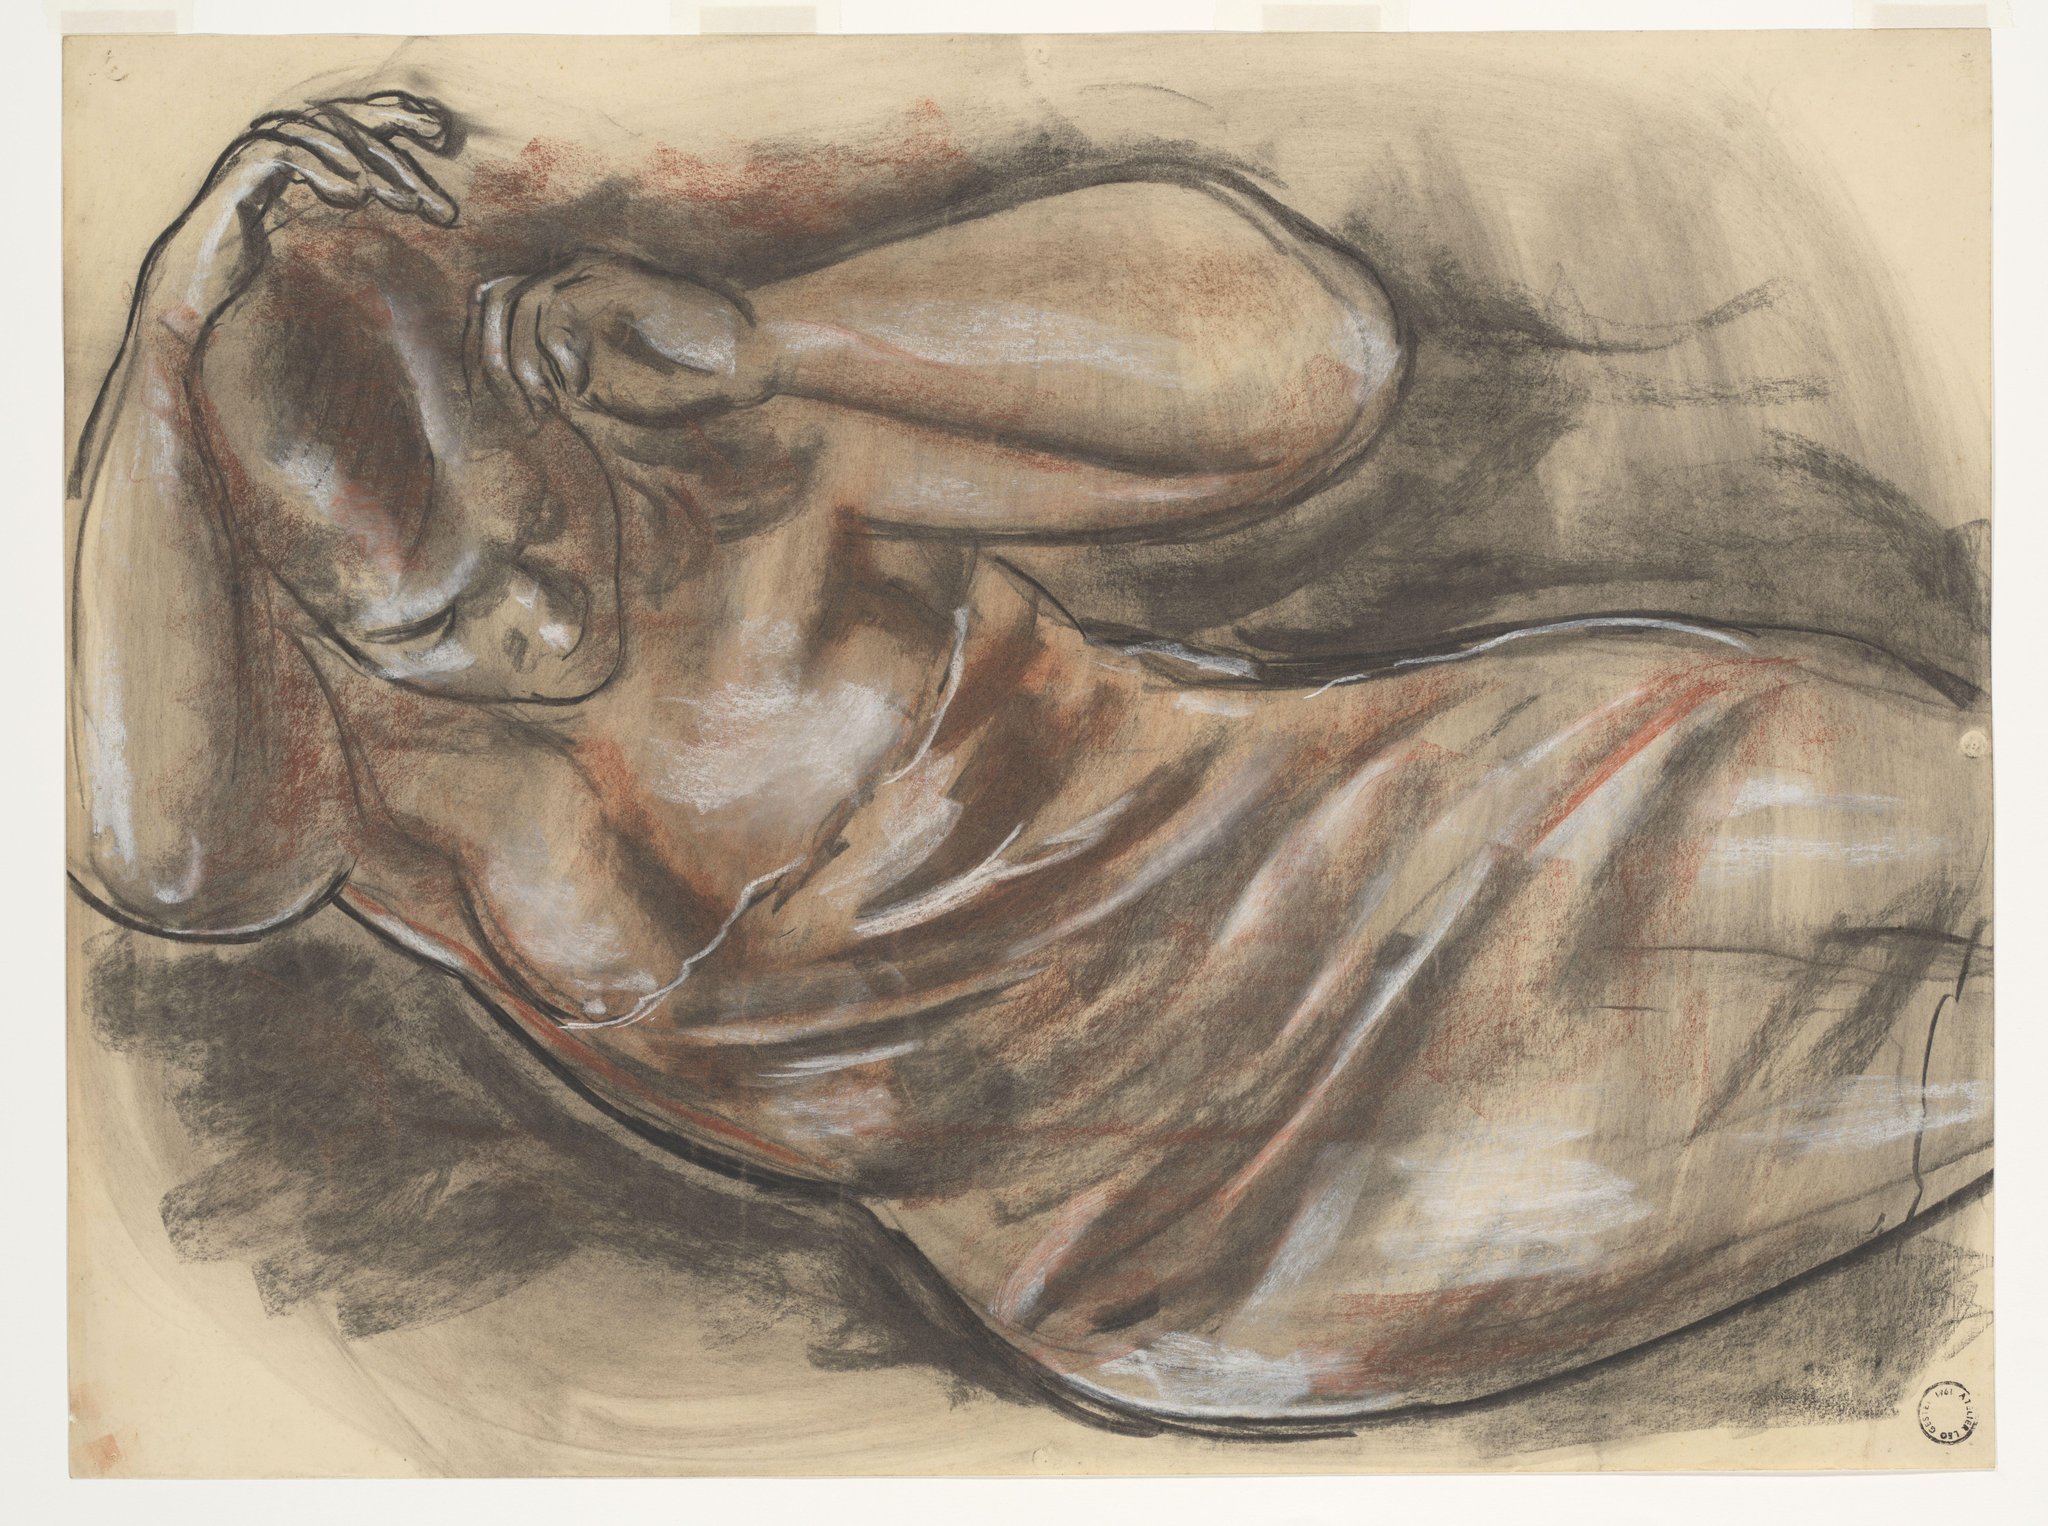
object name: drawing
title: Liggend naakt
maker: leo gestel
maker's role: draughtsman, print maker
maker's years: 1881-1941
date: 1930-1941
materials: chalk, charcoal, paper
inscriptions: workshop stamp (): ‘ATELIER LEO GESTEL 1941’, date (possibly false)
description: Liggende vrouw, haar handen onder haar hoofd rechtsonder, haar jurk tot net boven haar tepels naar beneden getrokken.